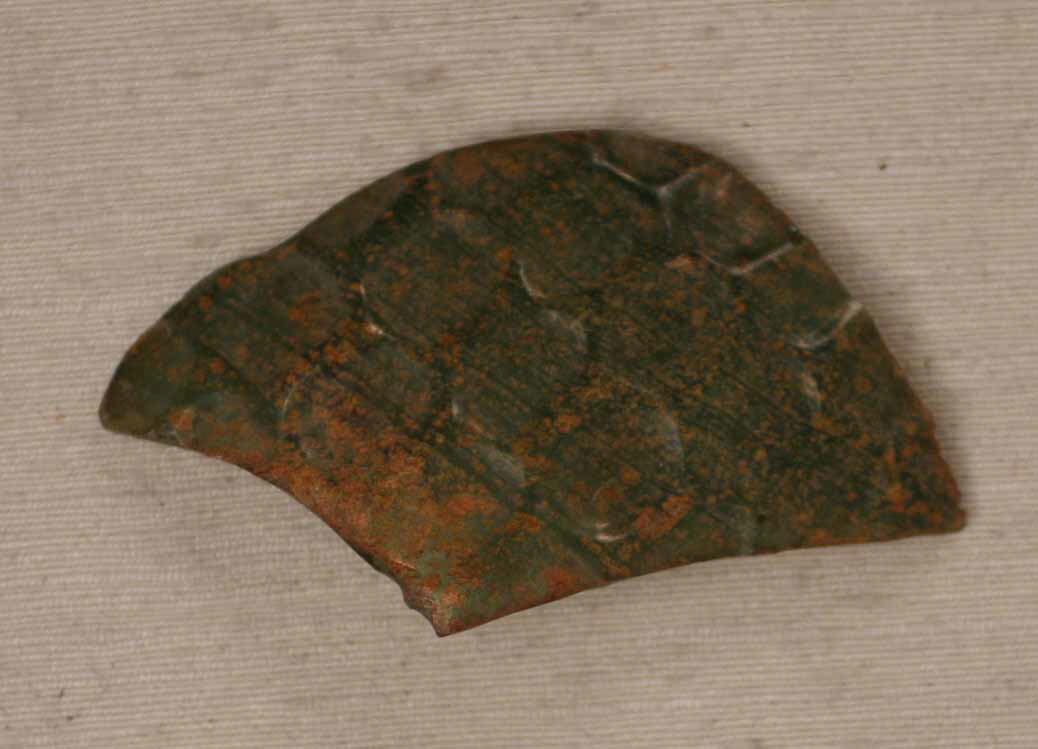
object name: fragment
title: Glass Fragment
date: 501-700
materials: glass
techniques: glassblowing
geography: iraq